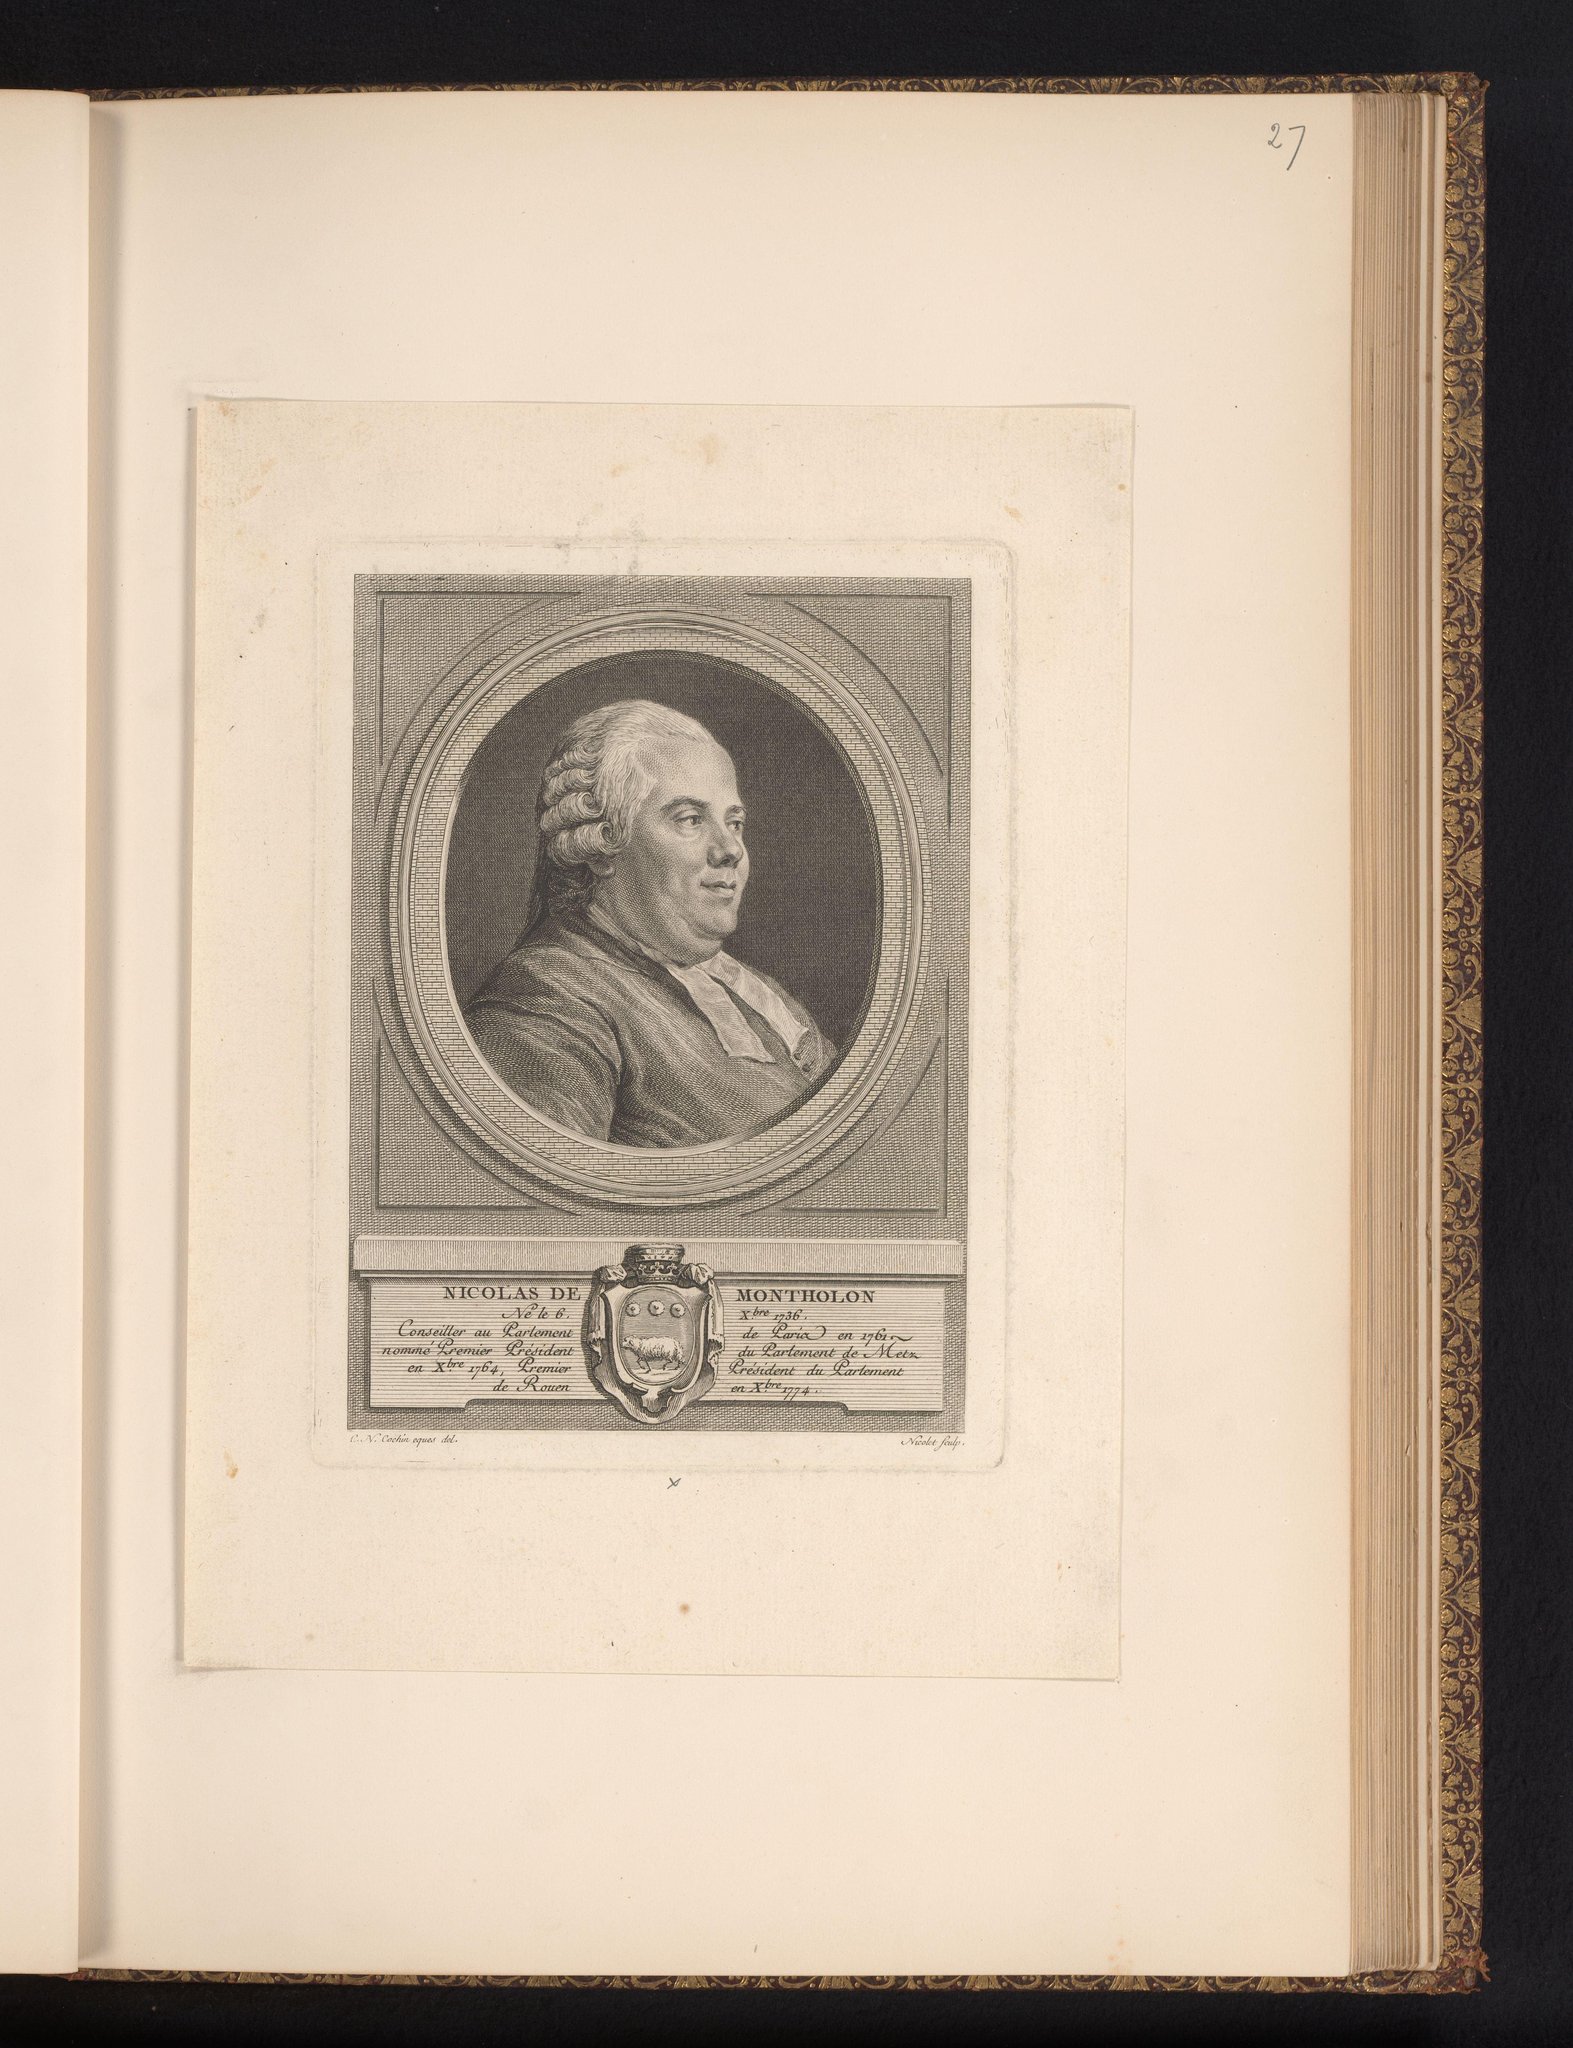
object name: print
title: Nicolas de Montholon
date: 1774-1806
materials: paper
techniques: engraving, etching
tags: paris, politician, historical persons